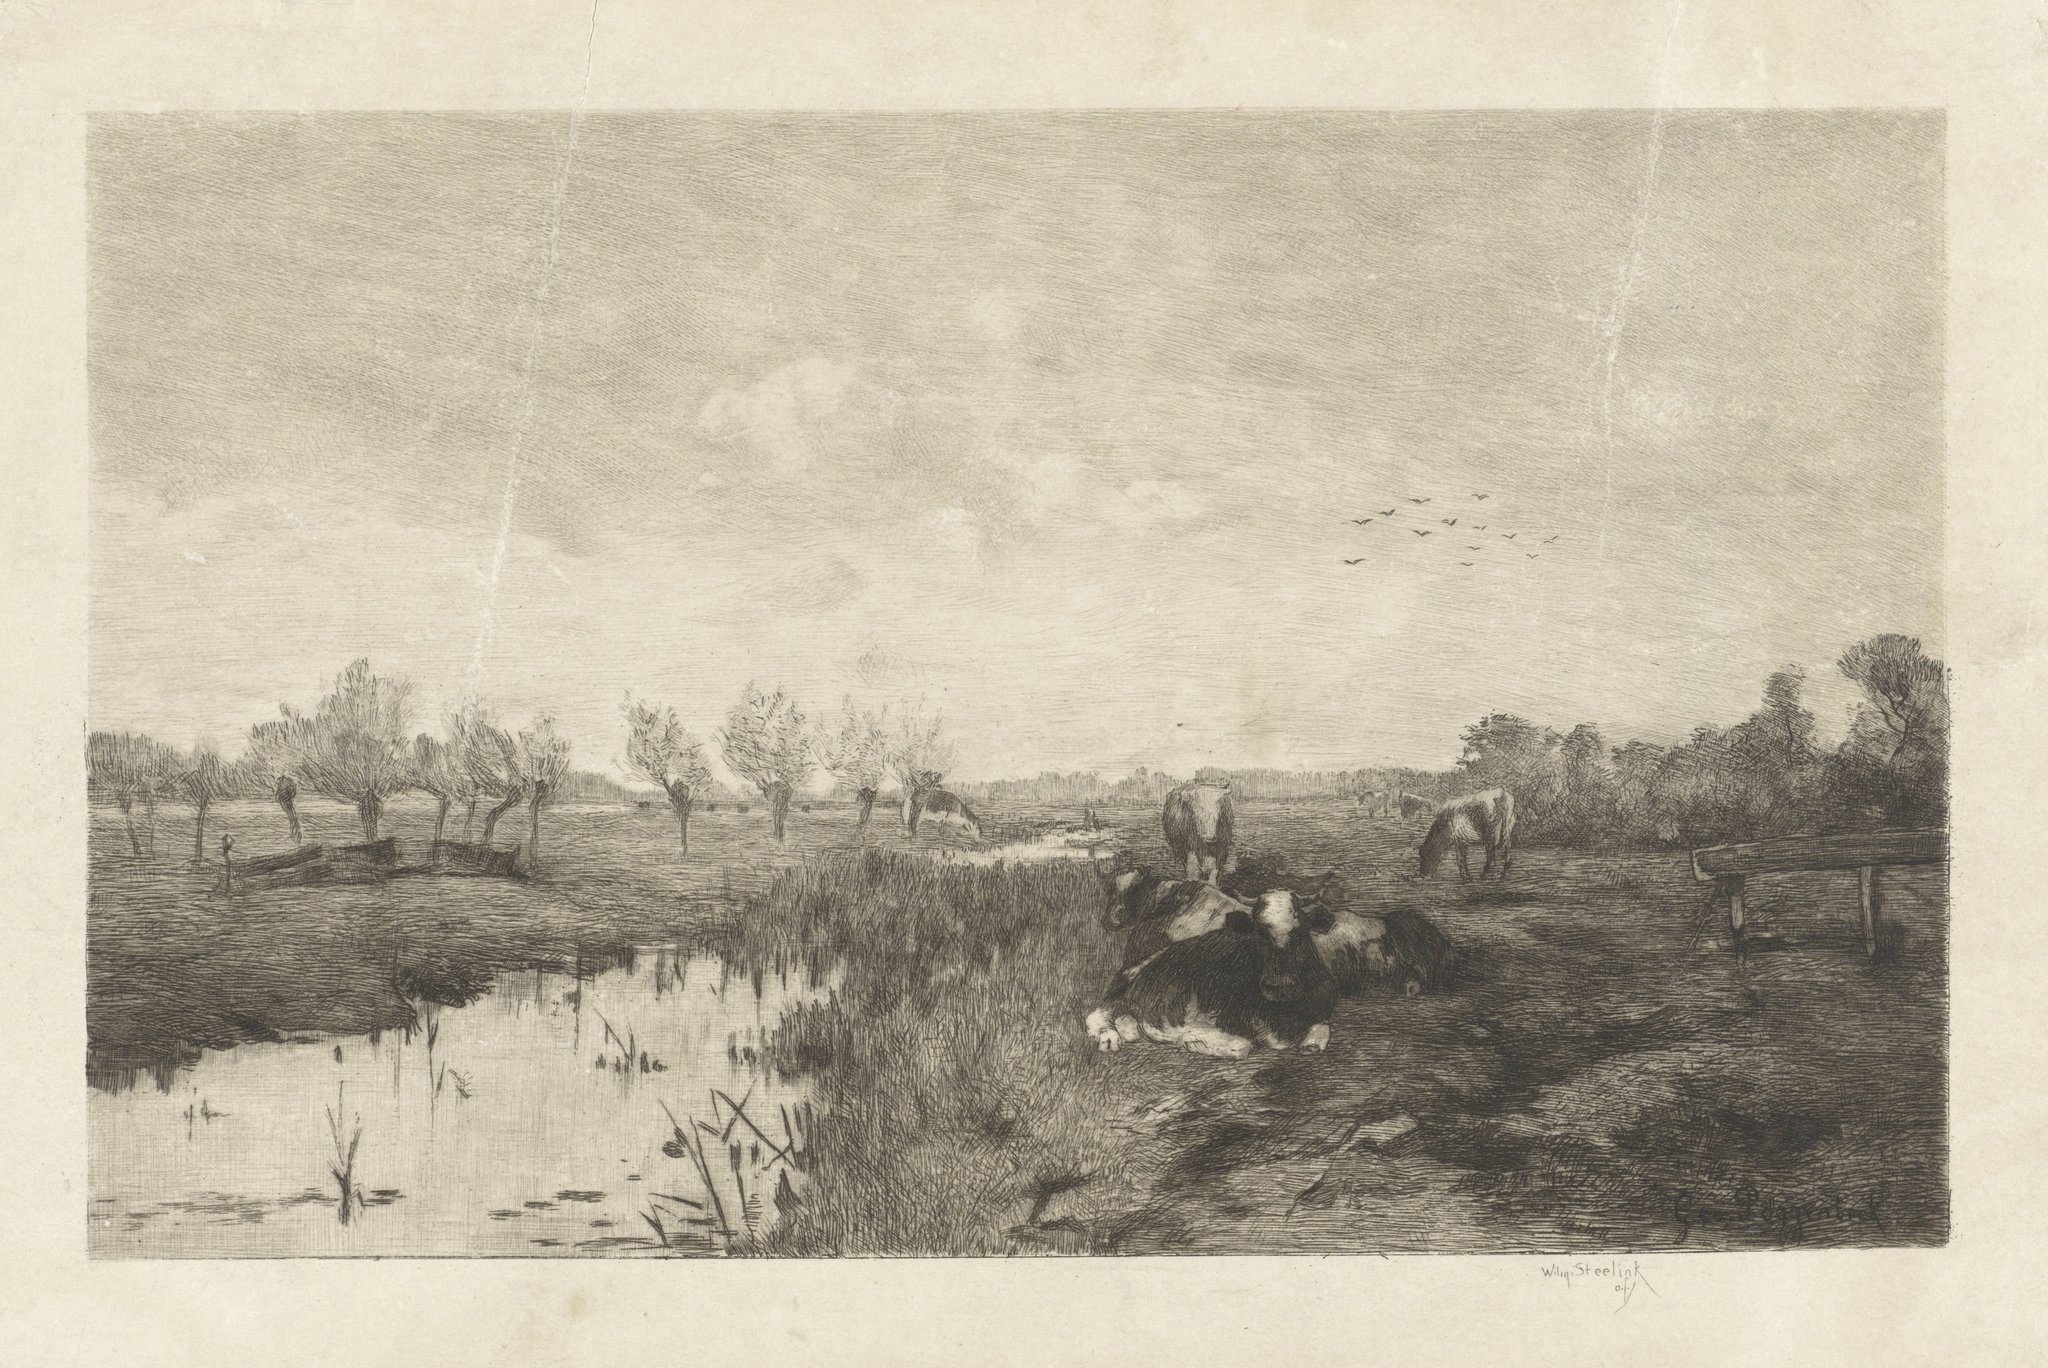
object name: print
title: Polderlandschap met koeien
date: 1894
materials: paper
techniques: etching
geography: netherlands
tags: cow, meadow, pasture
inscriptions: collector's mark: Lugt 2228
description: Langs een sloot liggen en staan koeien in een weiland. Links een rij knotwilgen.